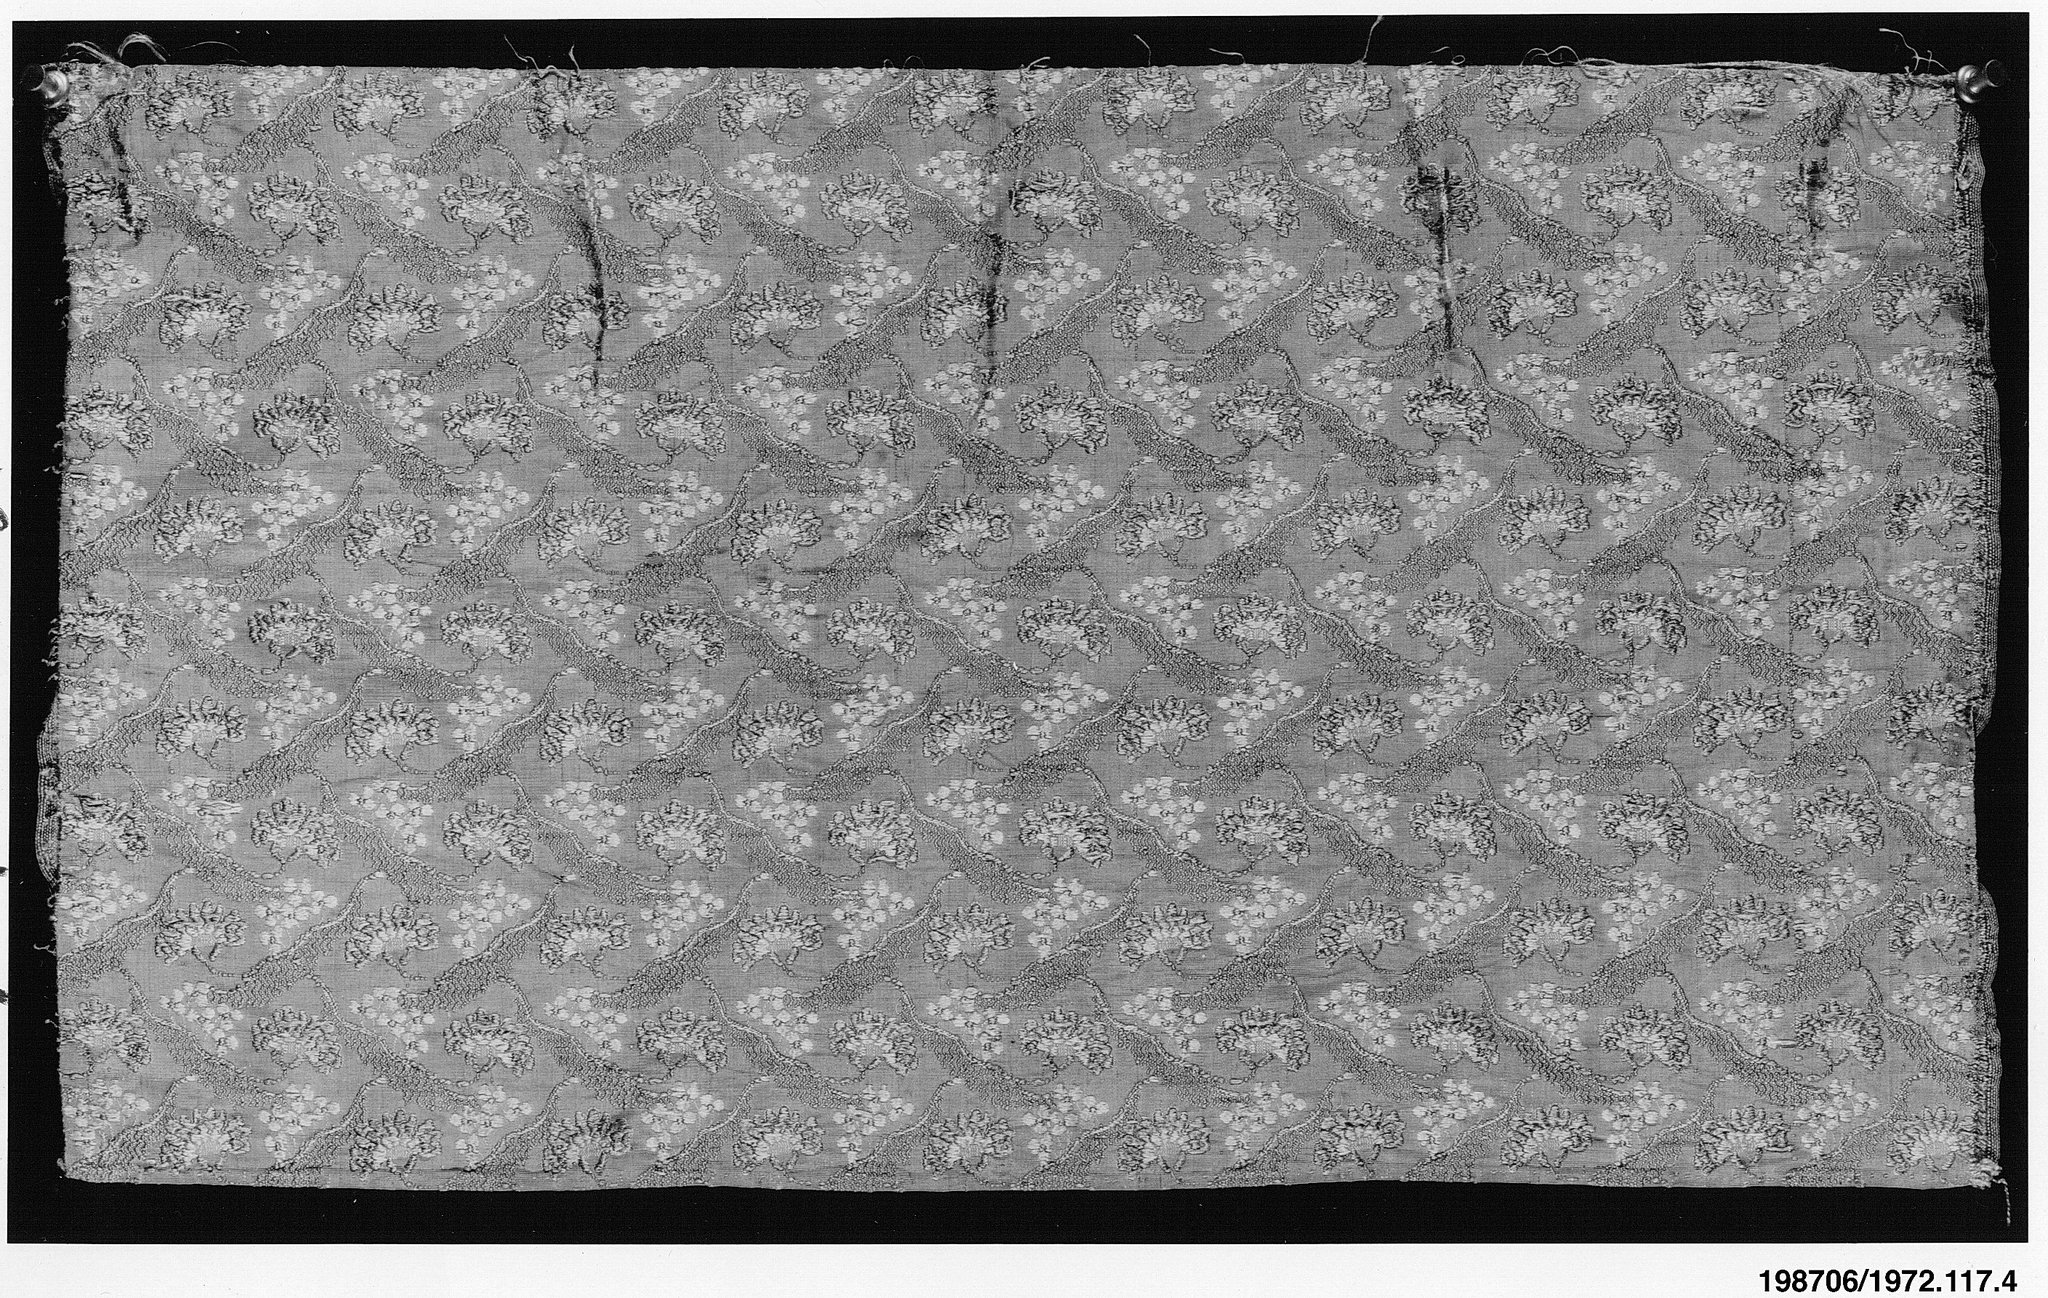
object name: piece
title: Piece of silk shirt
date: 1775-1824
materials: silk